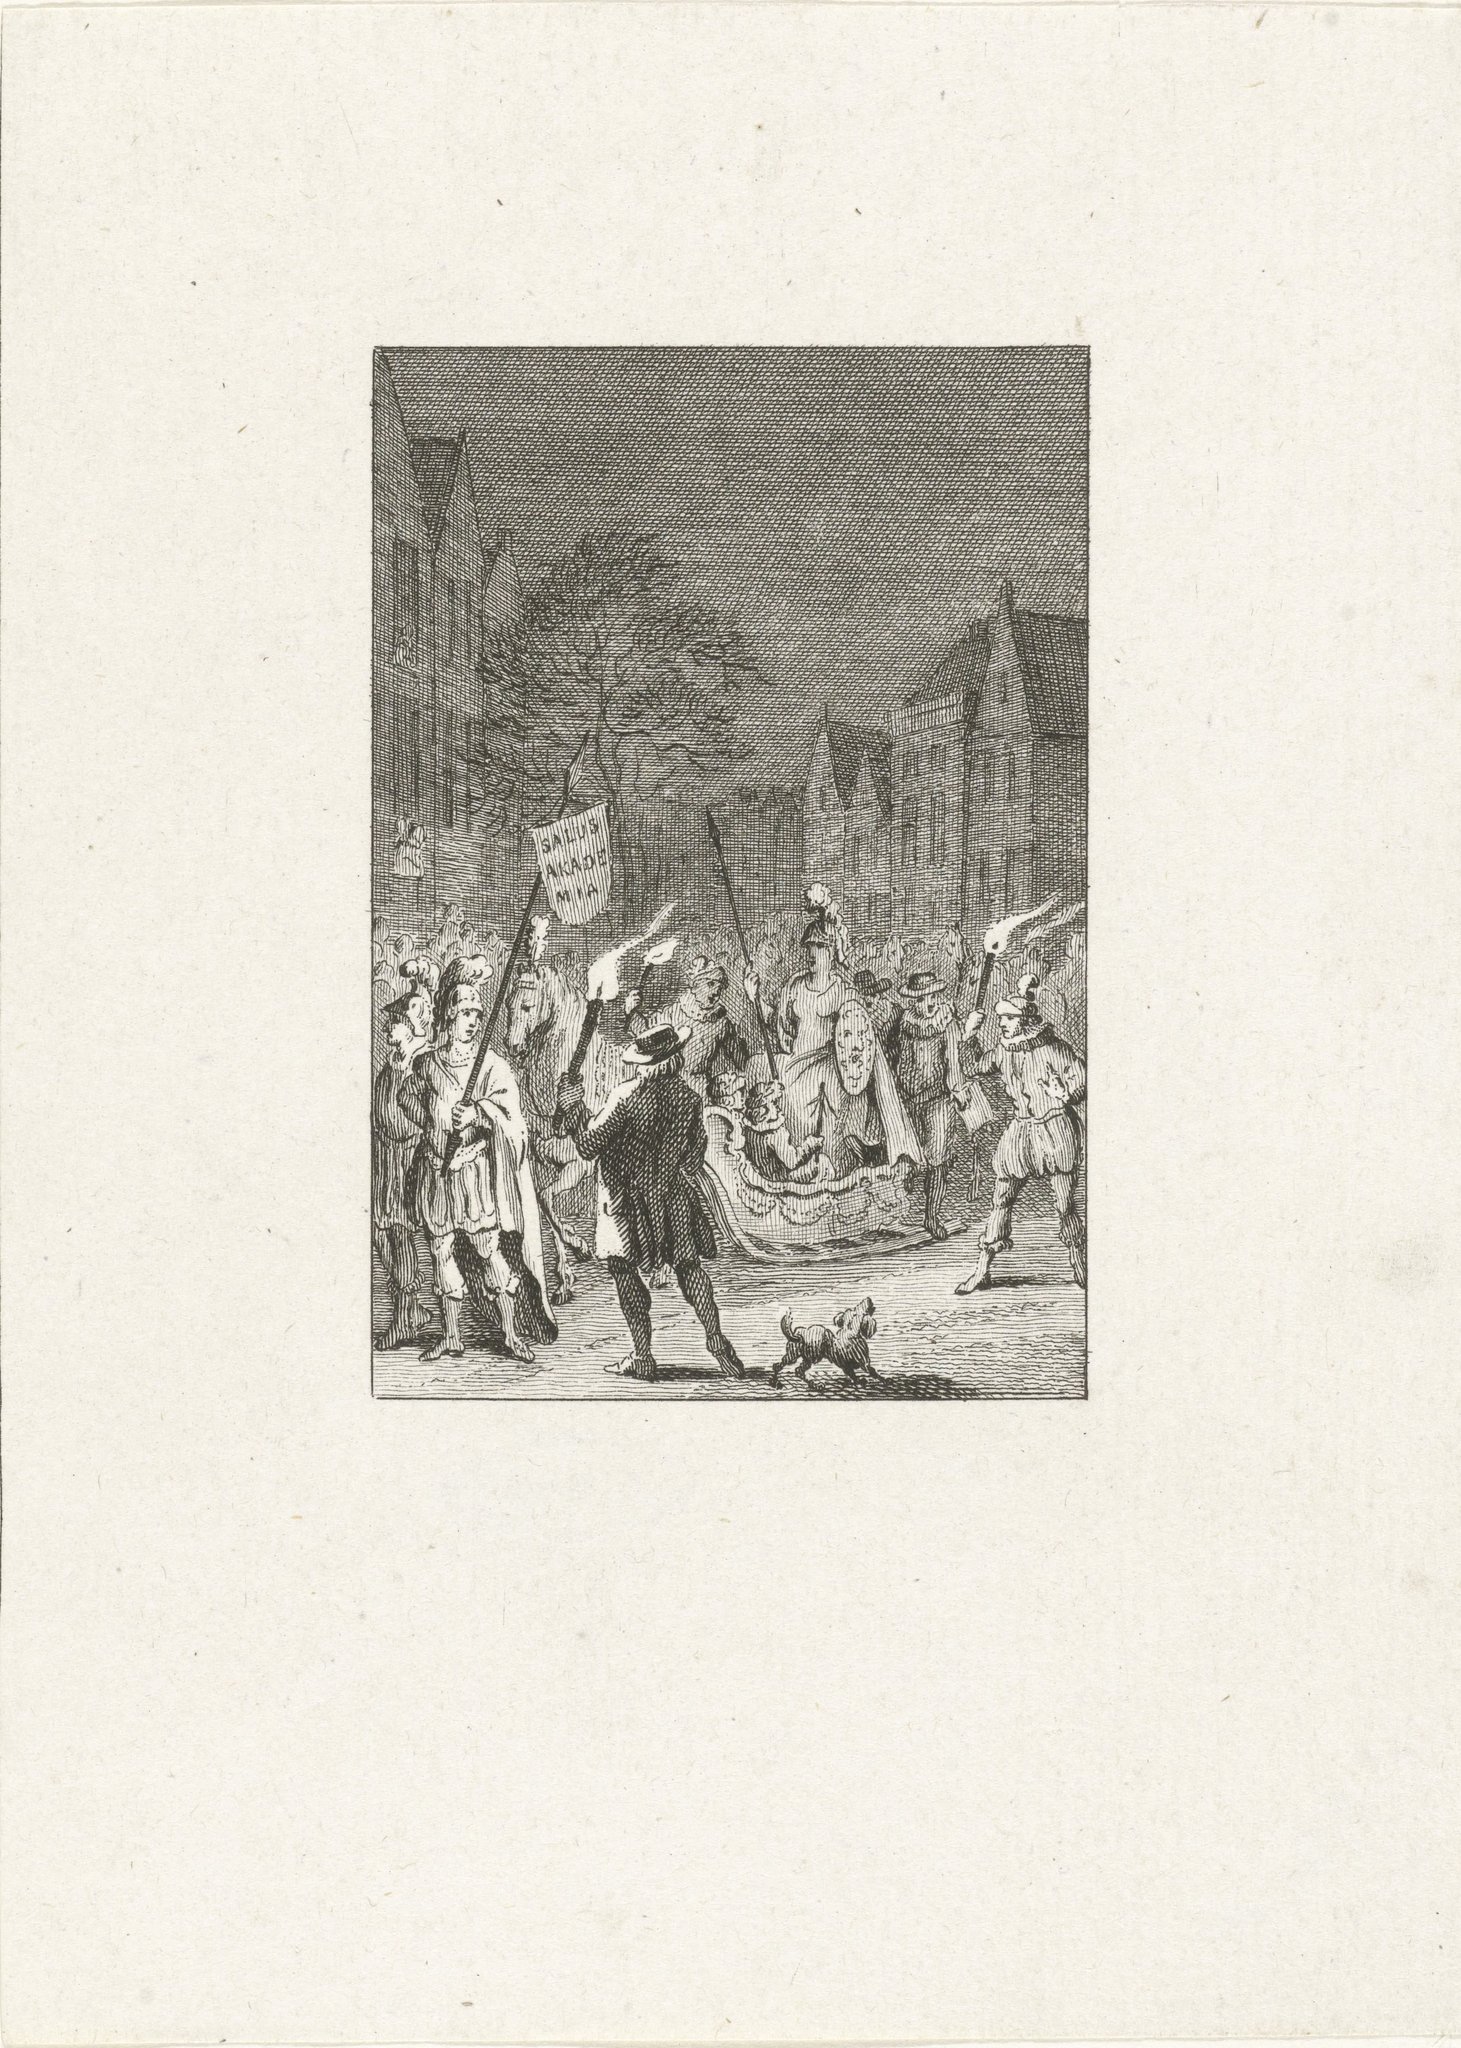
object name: print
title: Sledevaart door het Leidse genootschap Veniam Pro Laude, 1776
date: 1783-1795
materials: paper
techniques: etching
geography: northern netherlands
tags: sledge, sleigh (winter sports), commemoration of the founding of a university, leiden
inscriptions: collector's mark: Lugt 2228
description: De sledevaart op 24 januari 1776 georganiseerd door het Leidse genootschap Veniam Pro Laude bij gelegenheid van het Tweede Eeuwfeest van het Leids Ontzet (3 oktober 1574) en de oprichting van de Universiteit van Leiden (8 februari 1575).